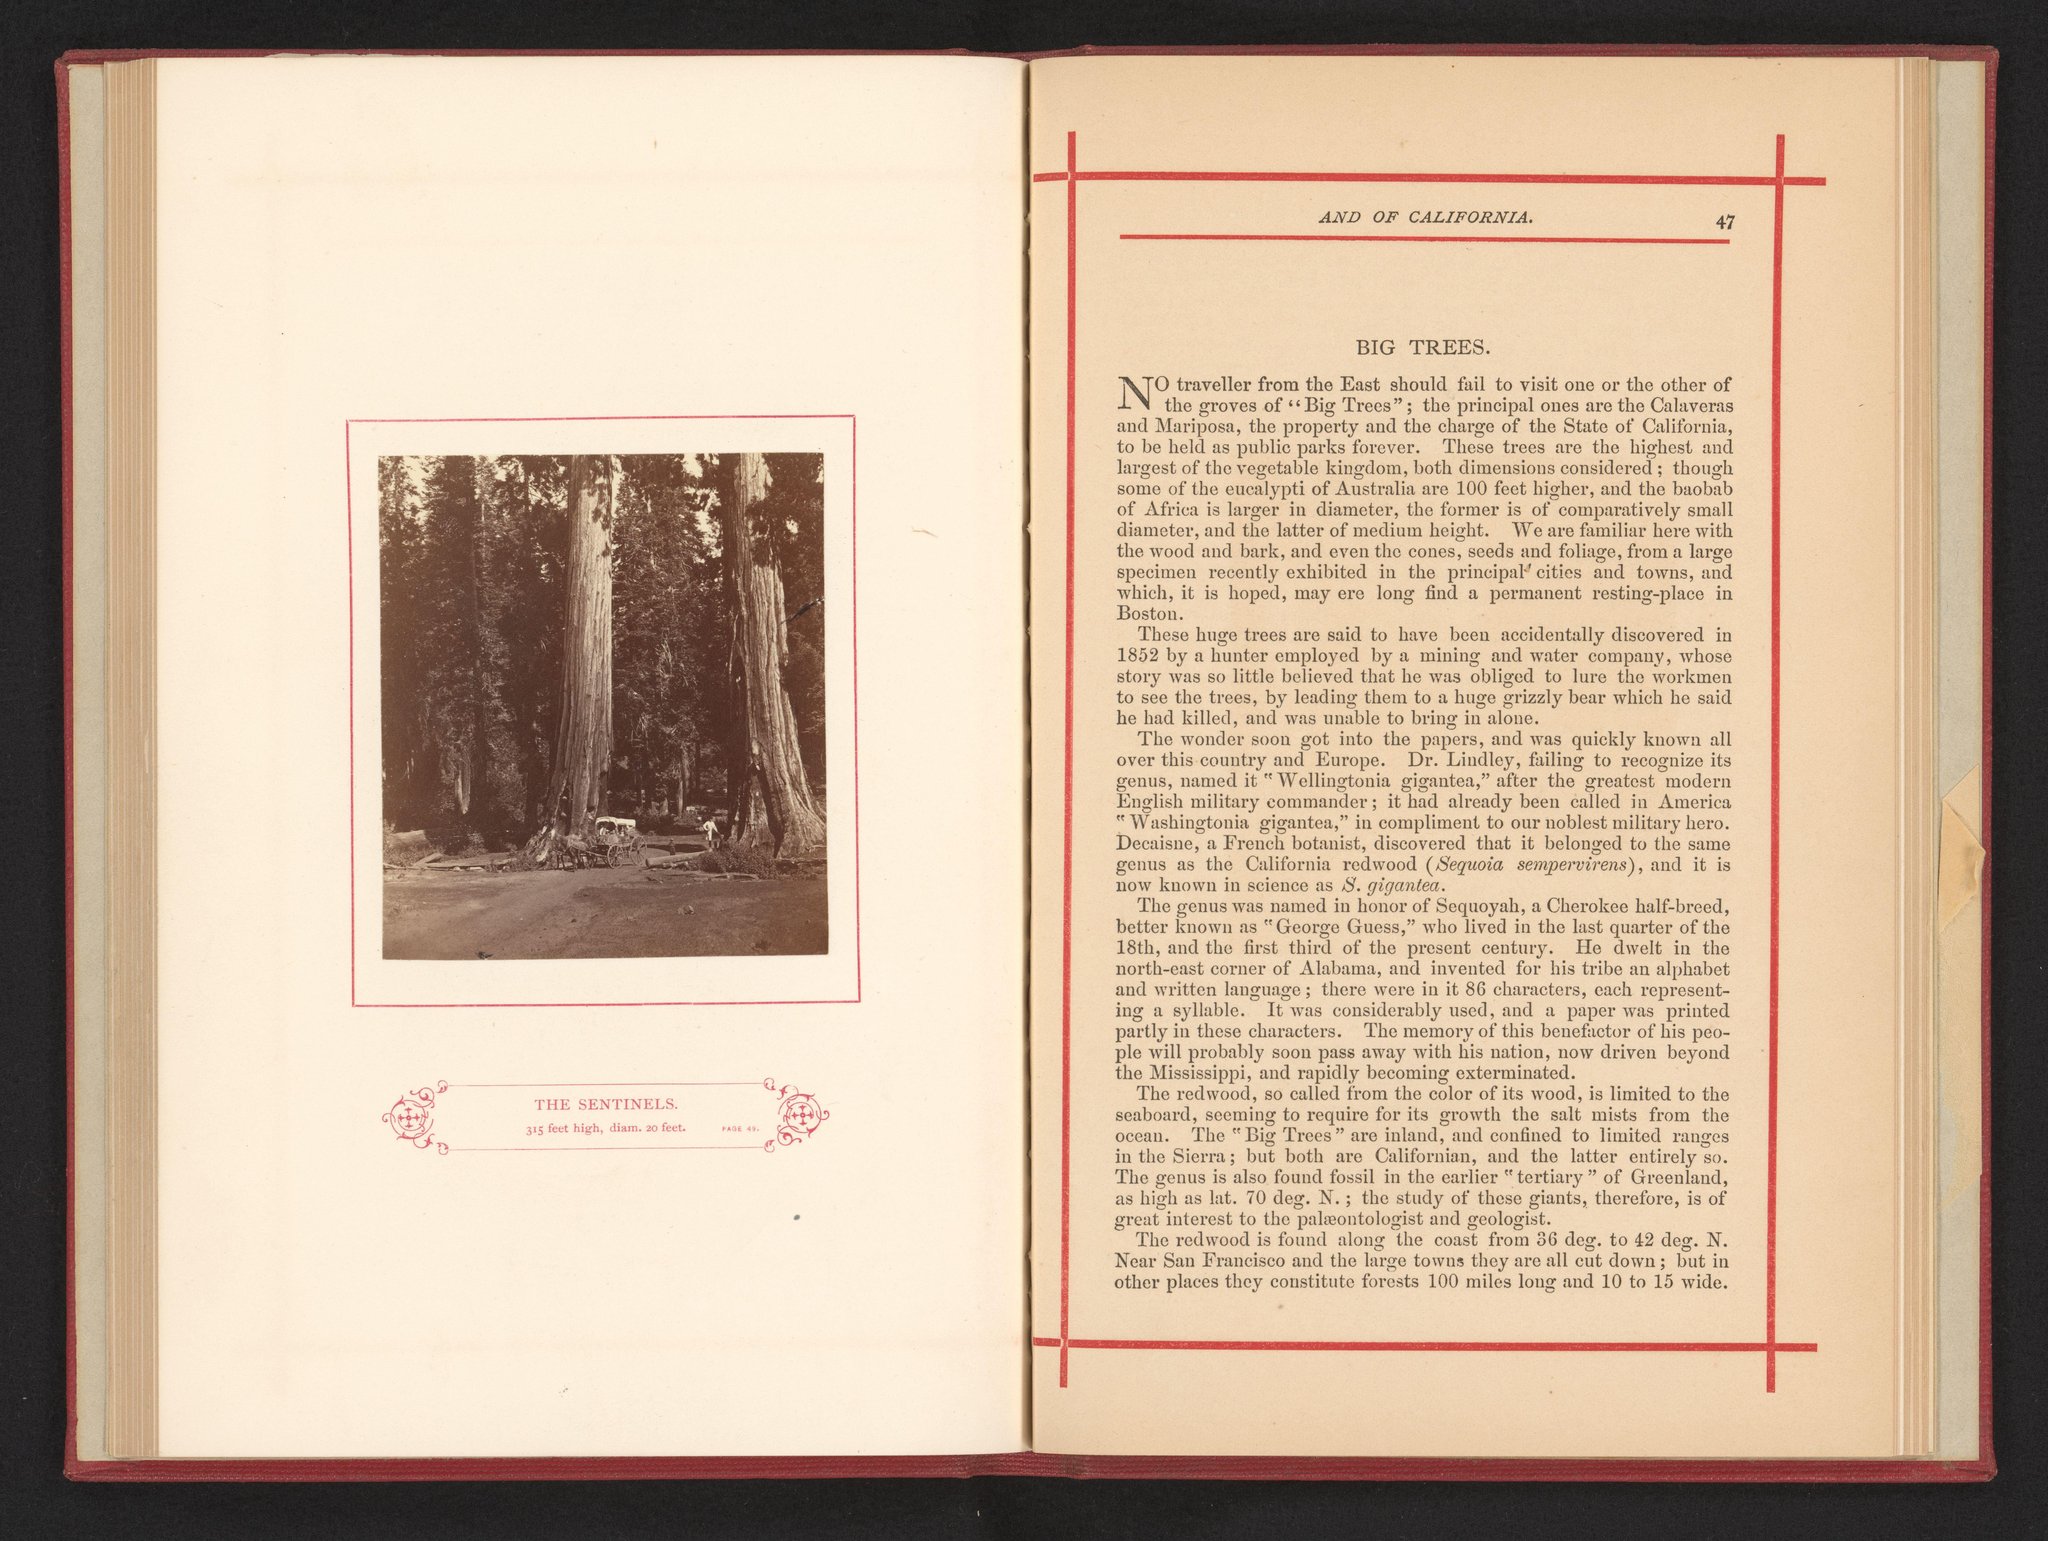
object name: page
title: Gezicht op Sequoia bomen en een paardenwagen in de Yosemite Valley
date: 1861-1871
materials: photographic support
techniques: albumen print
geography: yosemite valley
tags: four-wheeled vehicle drawn by one animal, trees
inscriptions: inscription: ‘315 feet high, diam. 20 feet. Page 49.’